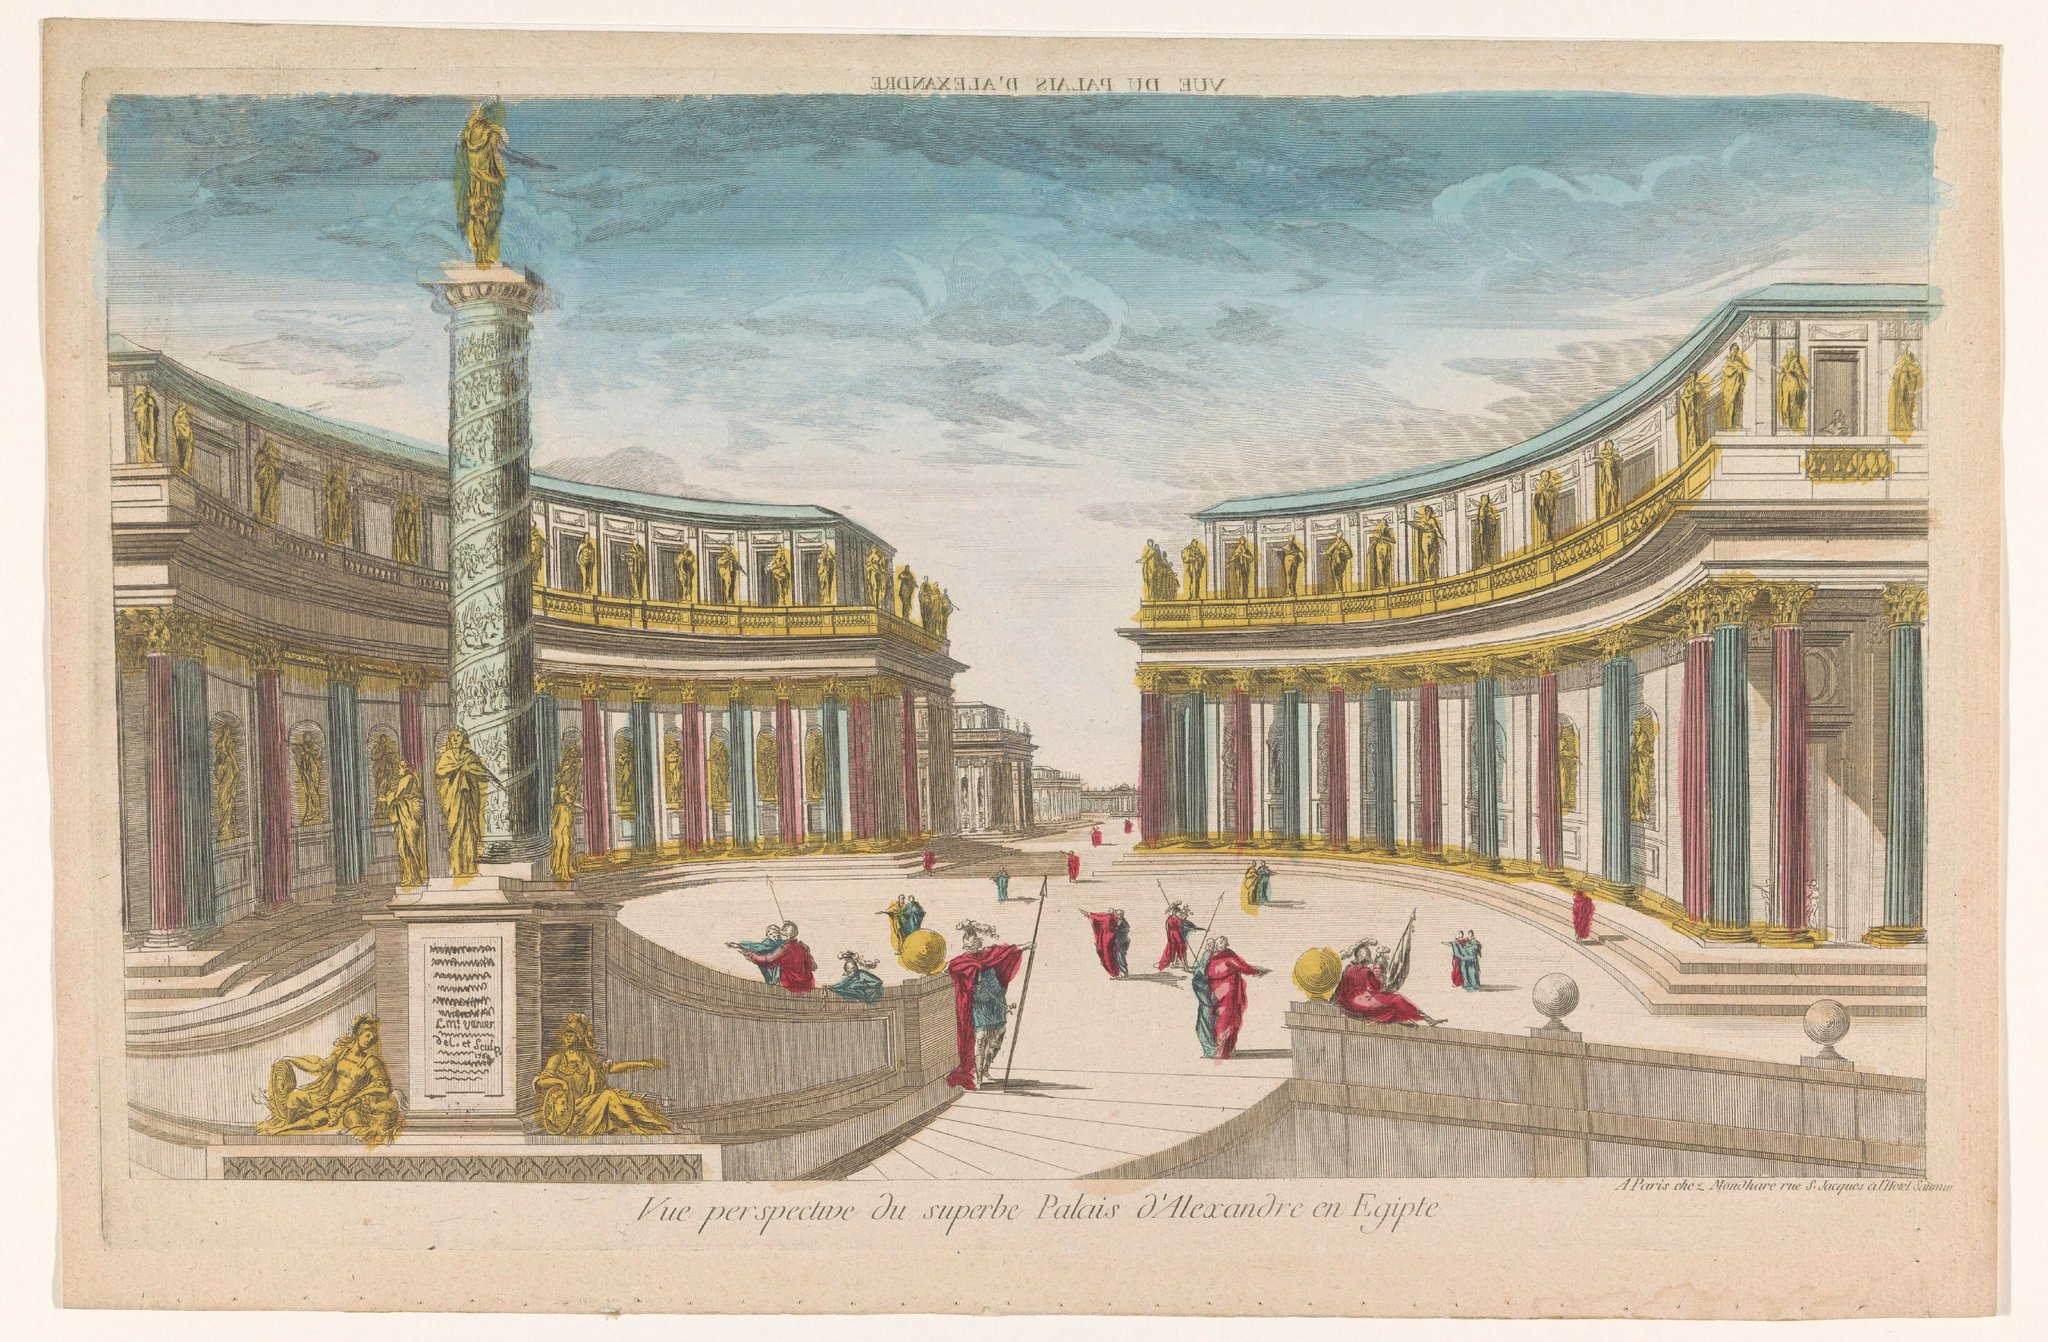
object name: opticaprent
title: Gezicht op een paleis te Alexandrië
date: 1762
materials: paper, watercolor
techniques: brush, etching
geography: france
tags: flight of steps, column, pillar ~ architecture, palace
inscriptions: watermark, collector's mark: Lugt 2166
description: Op de voorgrond links een zuill en een trap met beelden.